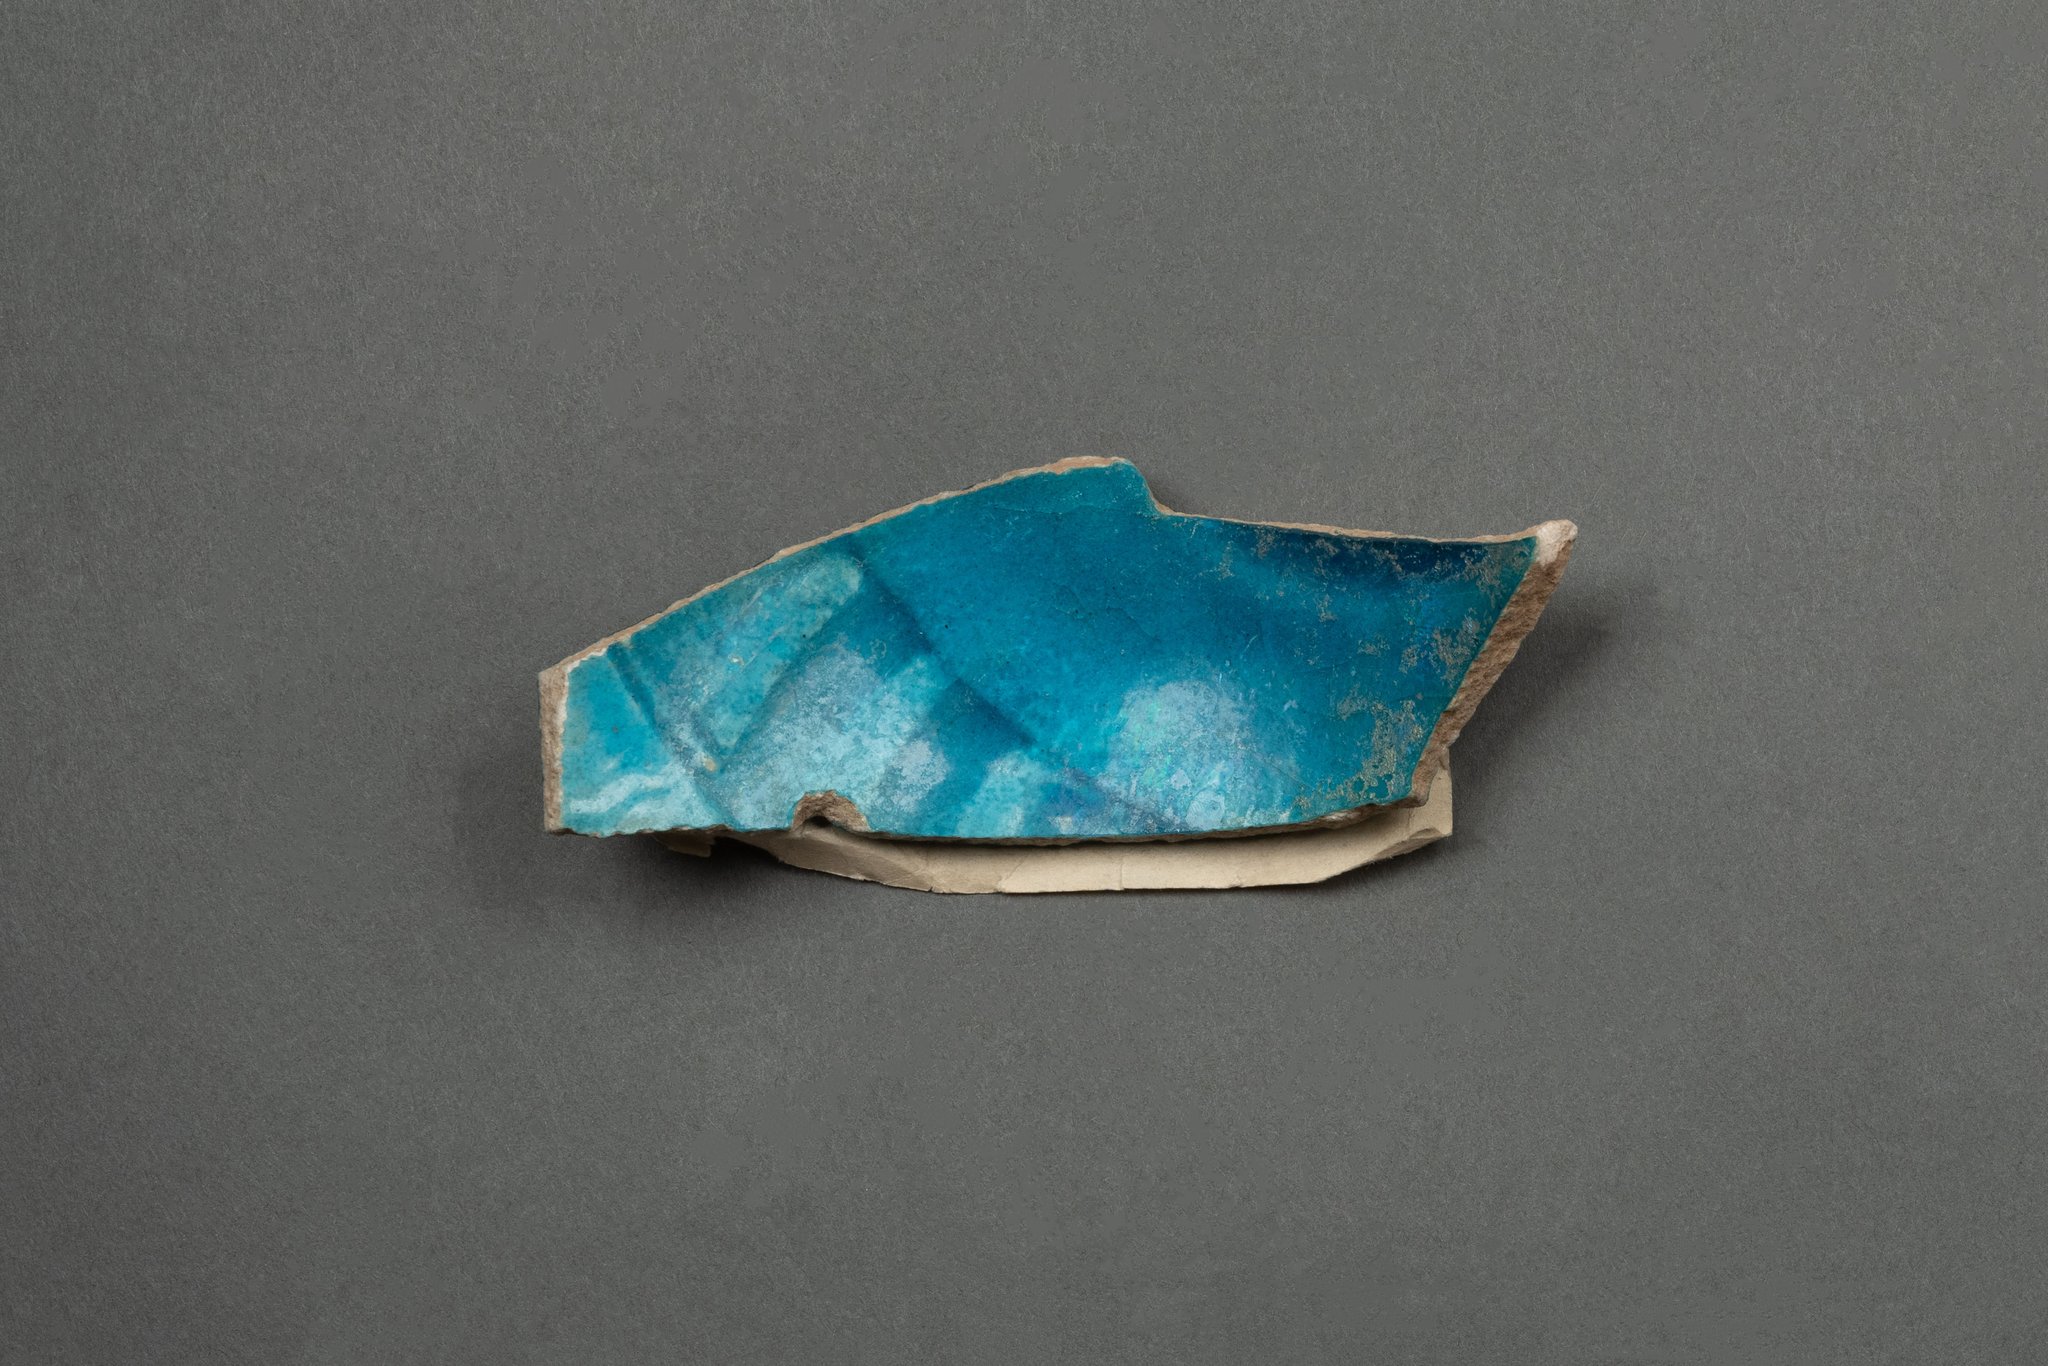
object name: fragment of a bowl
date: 1001-1200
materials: earthenware, glaze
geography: iran